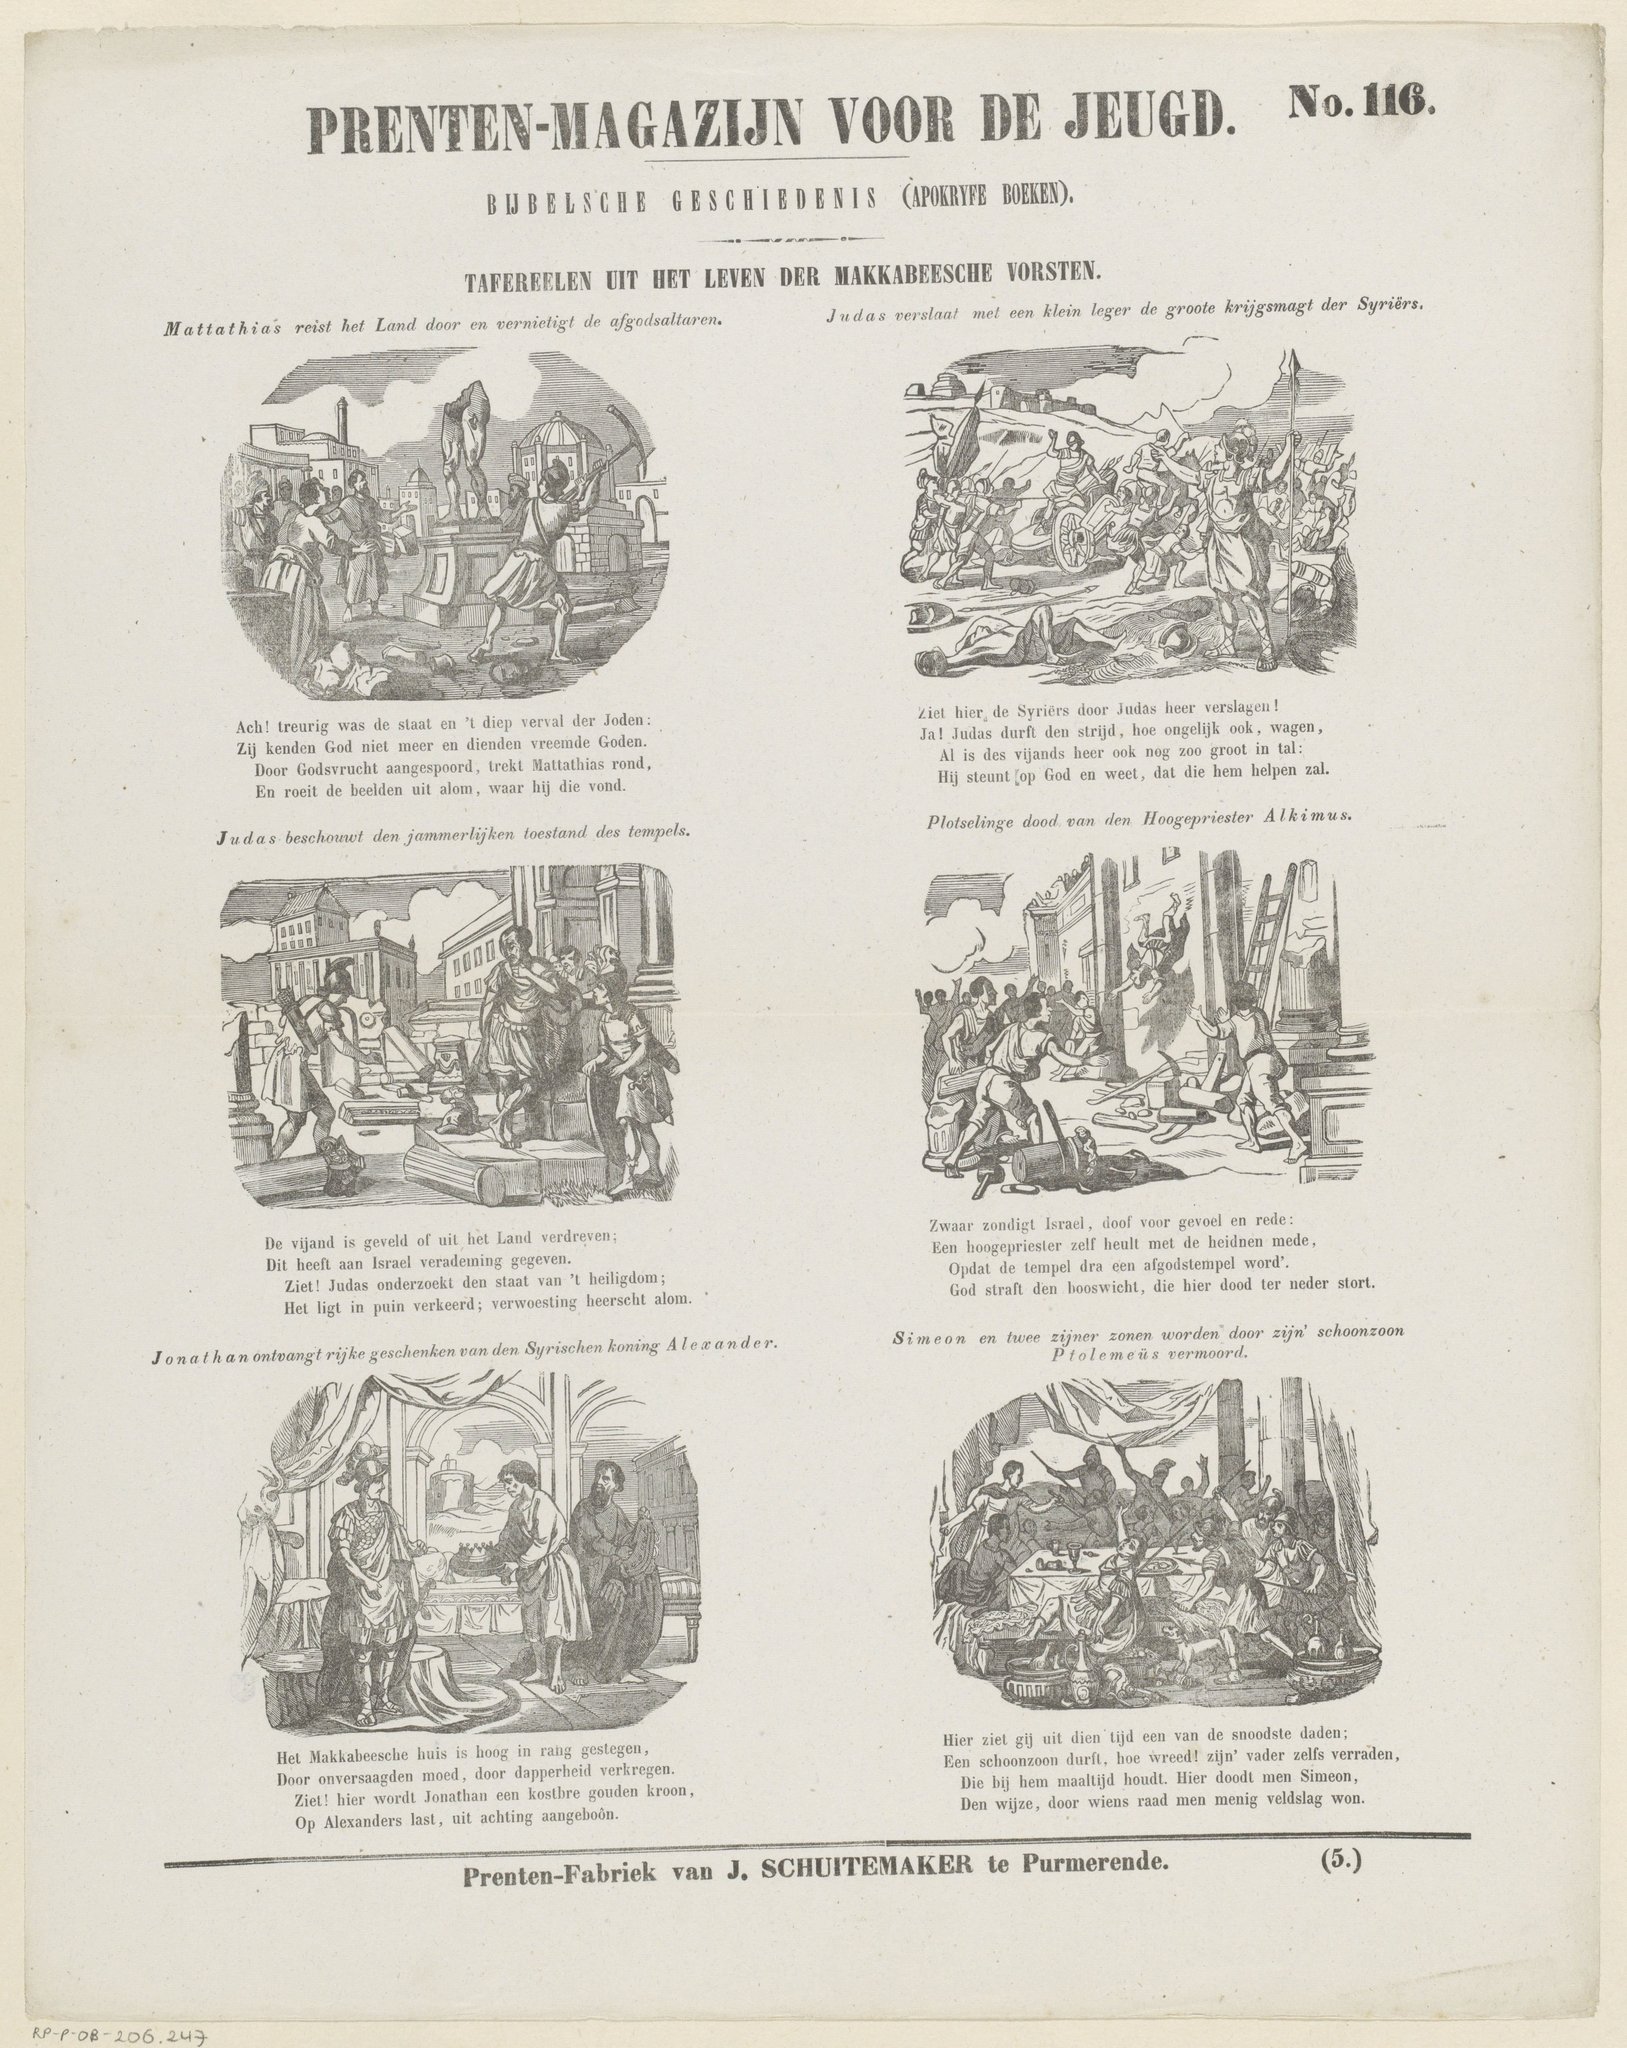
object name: print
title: Tafereelen uit het leven der Makkabeesche vorsten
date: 1850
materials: paper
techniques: letterpress printing, engraving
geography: purmerend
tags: (books of the) maccabees, old testament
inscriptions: collector's mark: Lugt 2760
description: Na voltooiing van de acht jaargangen van de reeks 'Prenten-magazijn voor de jeugd' in 1850 heeft Jan Schuitemaker al deze prenten heruitgegeven en omgenummerd als nr. 1 t/m 192. De oorspronkelijke jaargang wordt telkens nog vermeld rechtsonder op de prent. Binnen de jaargangen zijn prenten van hetzelfde thema in clusters van vier achter elkaar gezet.